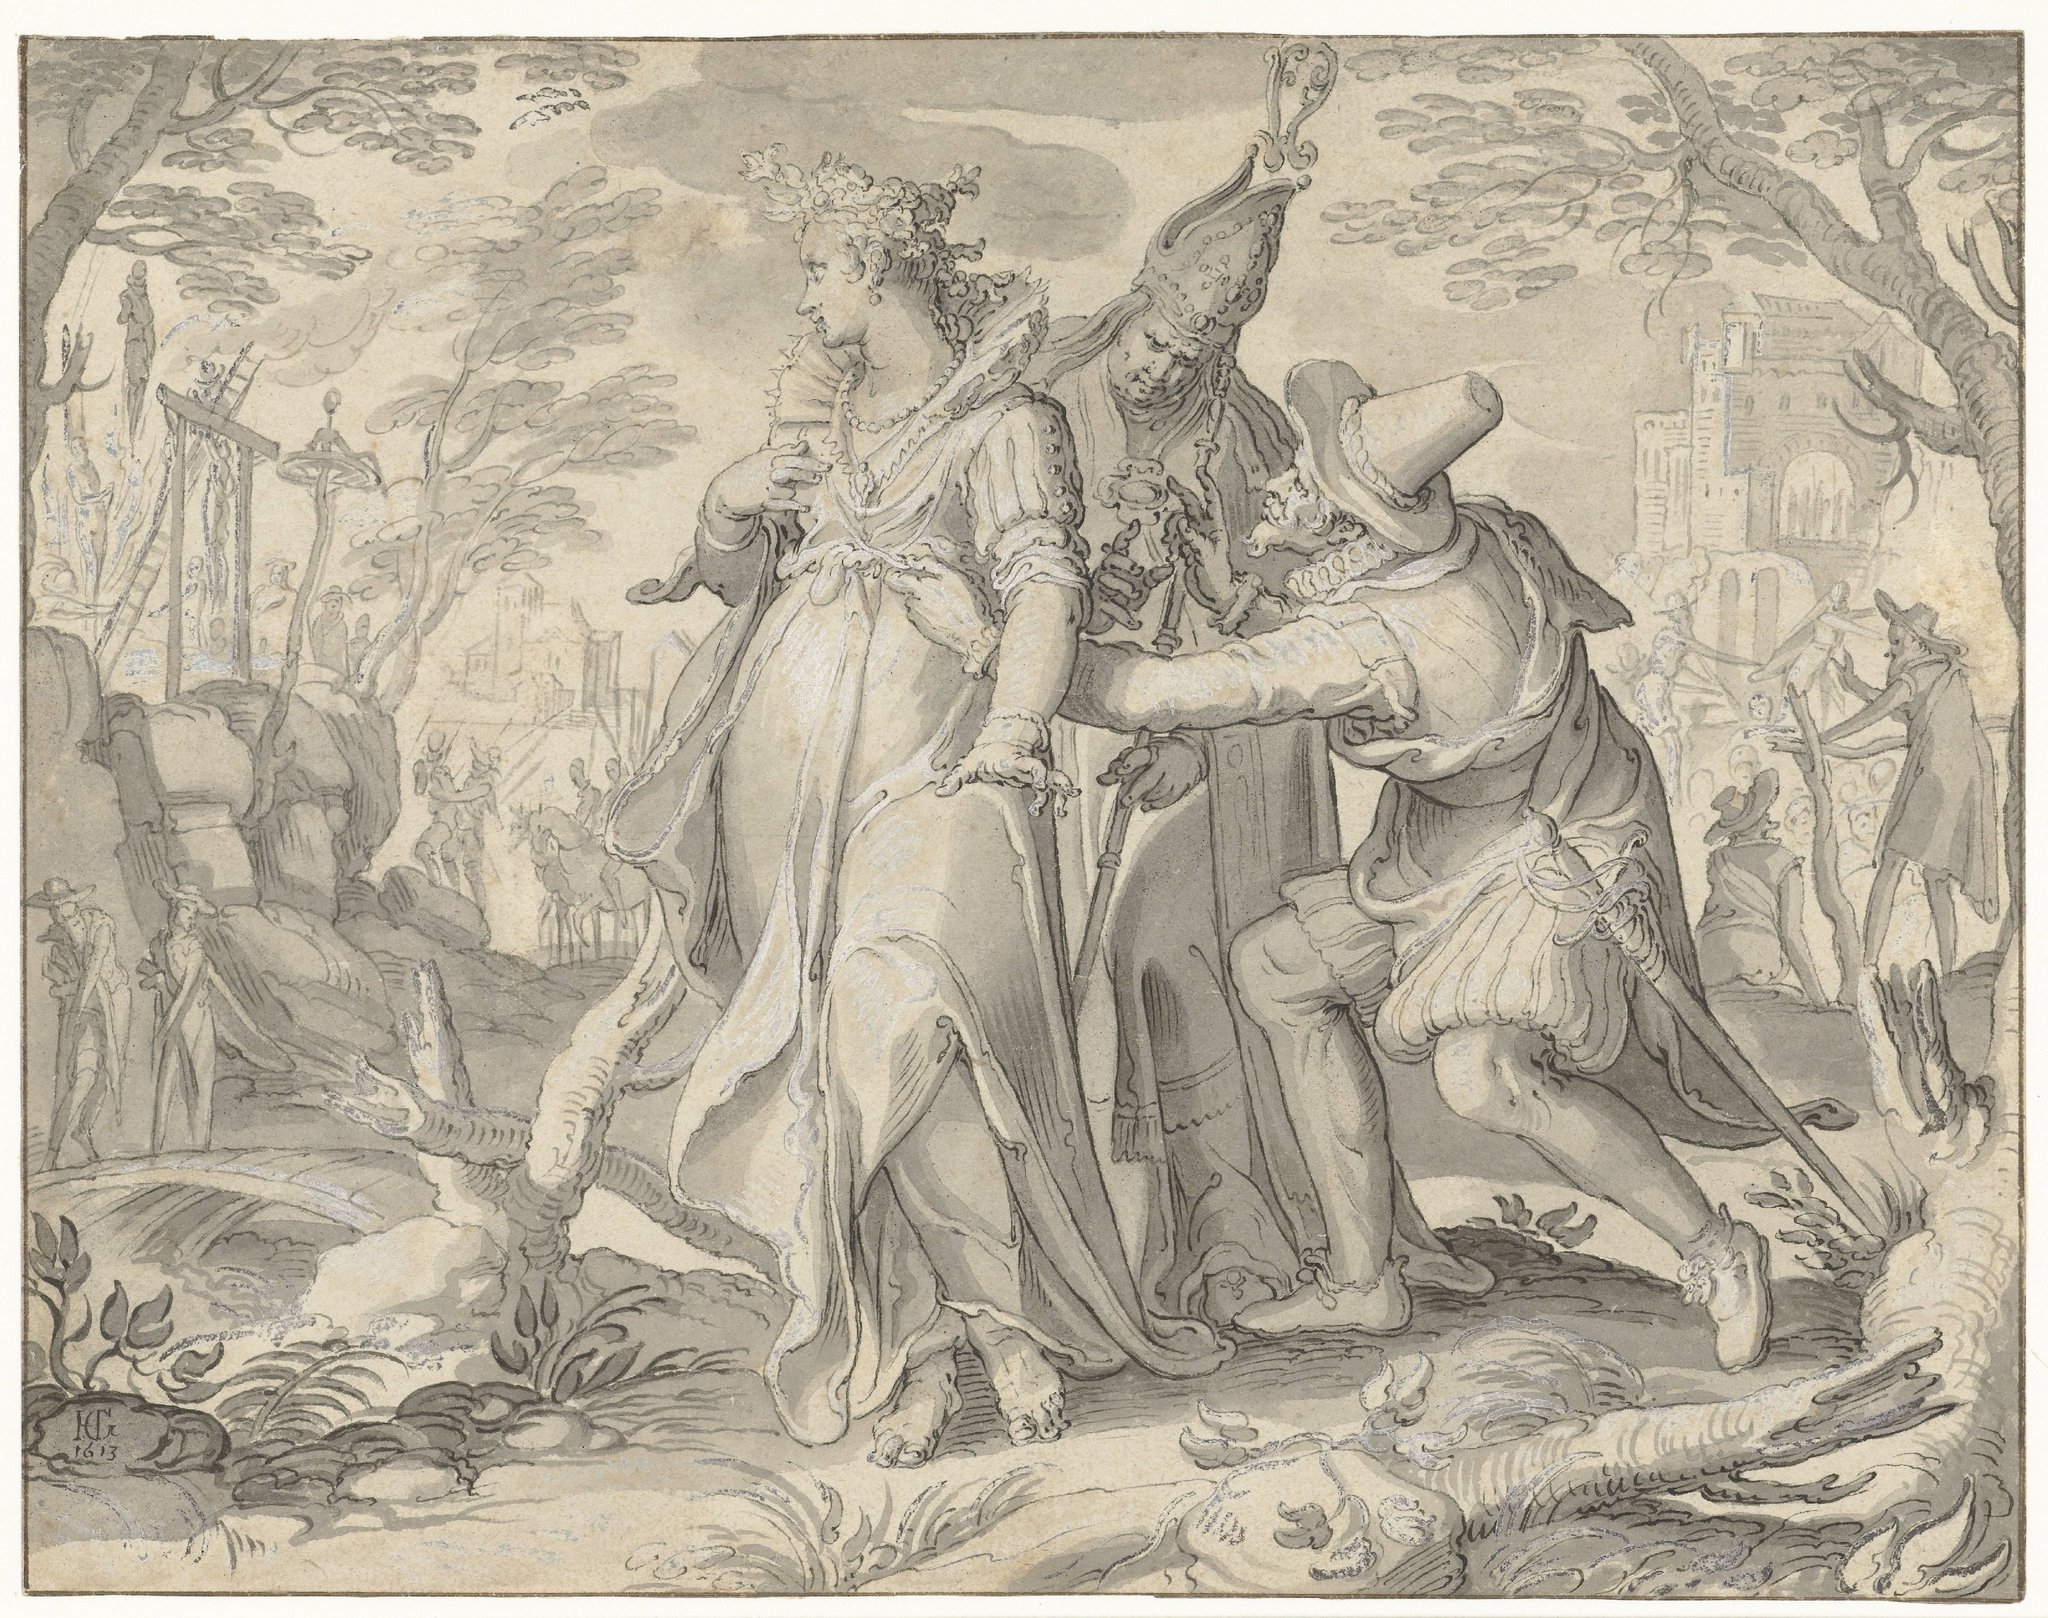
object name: drawing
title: Allegorieën Nederlandse Opstand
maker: Anonymous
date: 1613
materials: ink, paint, paper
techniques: brush, pen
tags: archbishop, bishop, etc. (roman catholic), personifications of countries, nations, states, districts, etc., execution of heretic, e.g. by burning at the stake, 'auto-da-fé', violent death by burning at the stake; pyre, theft, robbery, low countries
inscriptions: mark: ‘Goltzius, m e nr. 10’, signature and date: ‘HG 1613’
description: Allegorische voorstelling van de Nederlanden bedreigd door de rooms-katholieke kerk en door de Geuzen of het Spaanse leger.